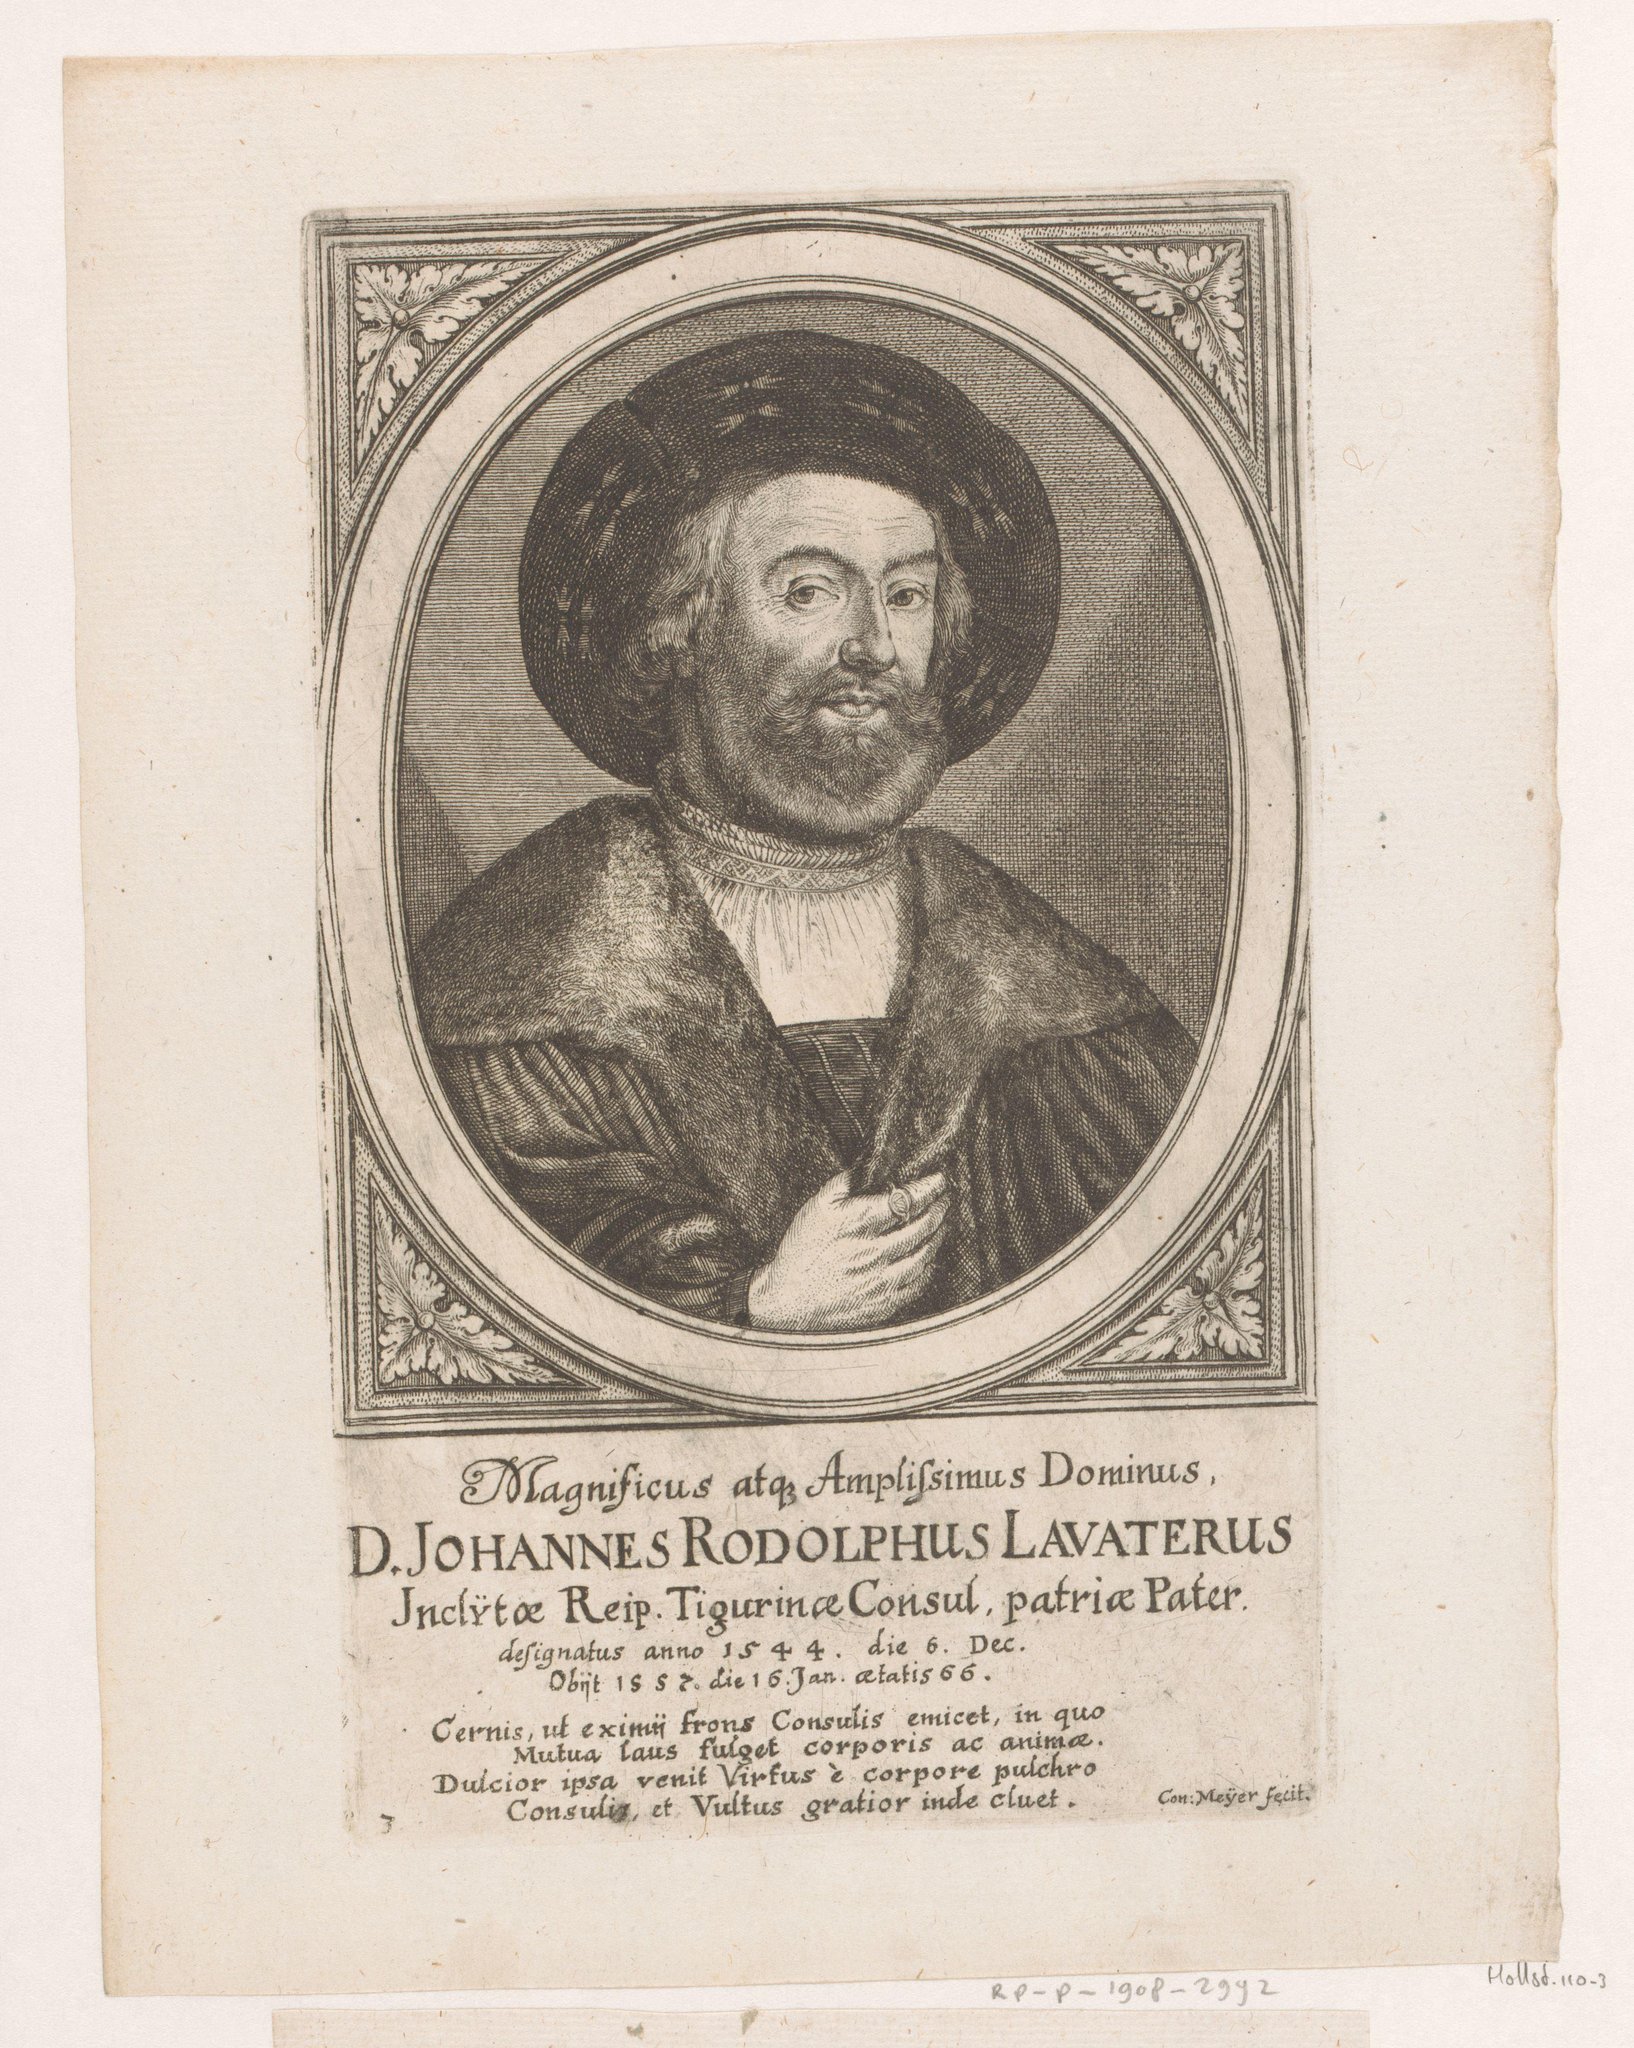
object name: print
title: Portret van Johann Rudolf Lavater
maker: conrad meyer (i)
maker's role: painter, print maker, publisher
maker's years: 1618-1689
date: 1657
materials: paper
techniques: engraving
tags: mayor, burgomaster, historical persons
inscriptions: collector's mark: Lugt 2228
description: Onderdeel van een serie van 67(?) portretten van burgemeesters van Zürich. Zie Hollstein German 110, 1-26.